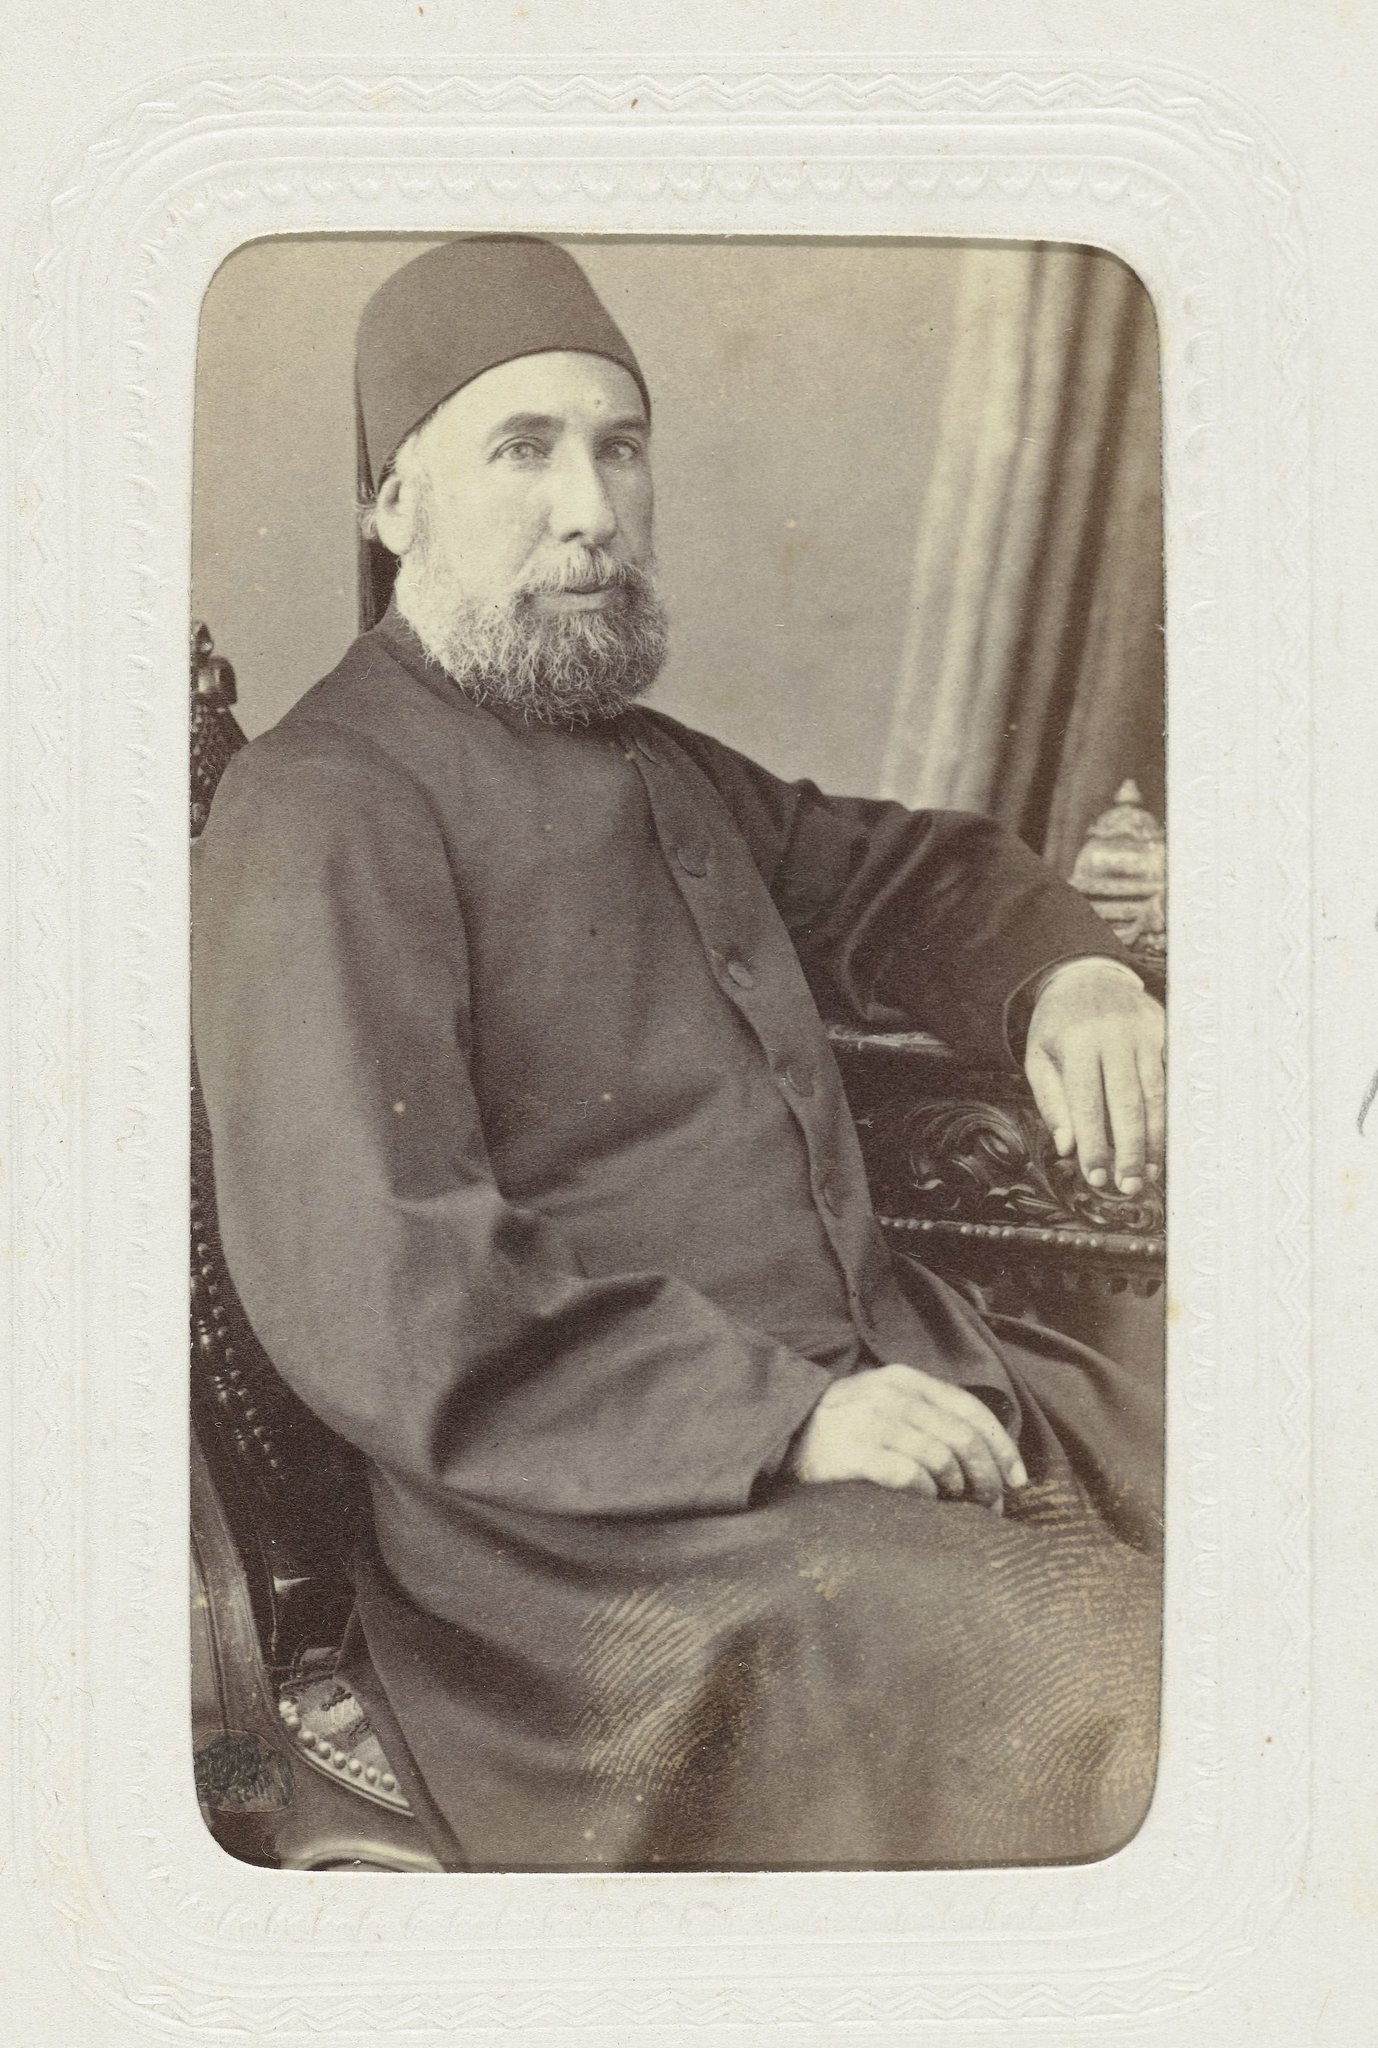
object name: carte de visite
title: Portret van Salek Effendi Hib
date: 1863-1866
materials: cardboard, paper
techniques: albumen print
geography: istanbul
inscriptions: name: ‘Abdullah Freres’, name: ‘Salek Effendi Hib’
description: Studioportret van een man zittend aan tafel met snor en baard en een fez. De afgebeelde man is vermoedelijk de heer Salek Effendi Hib.